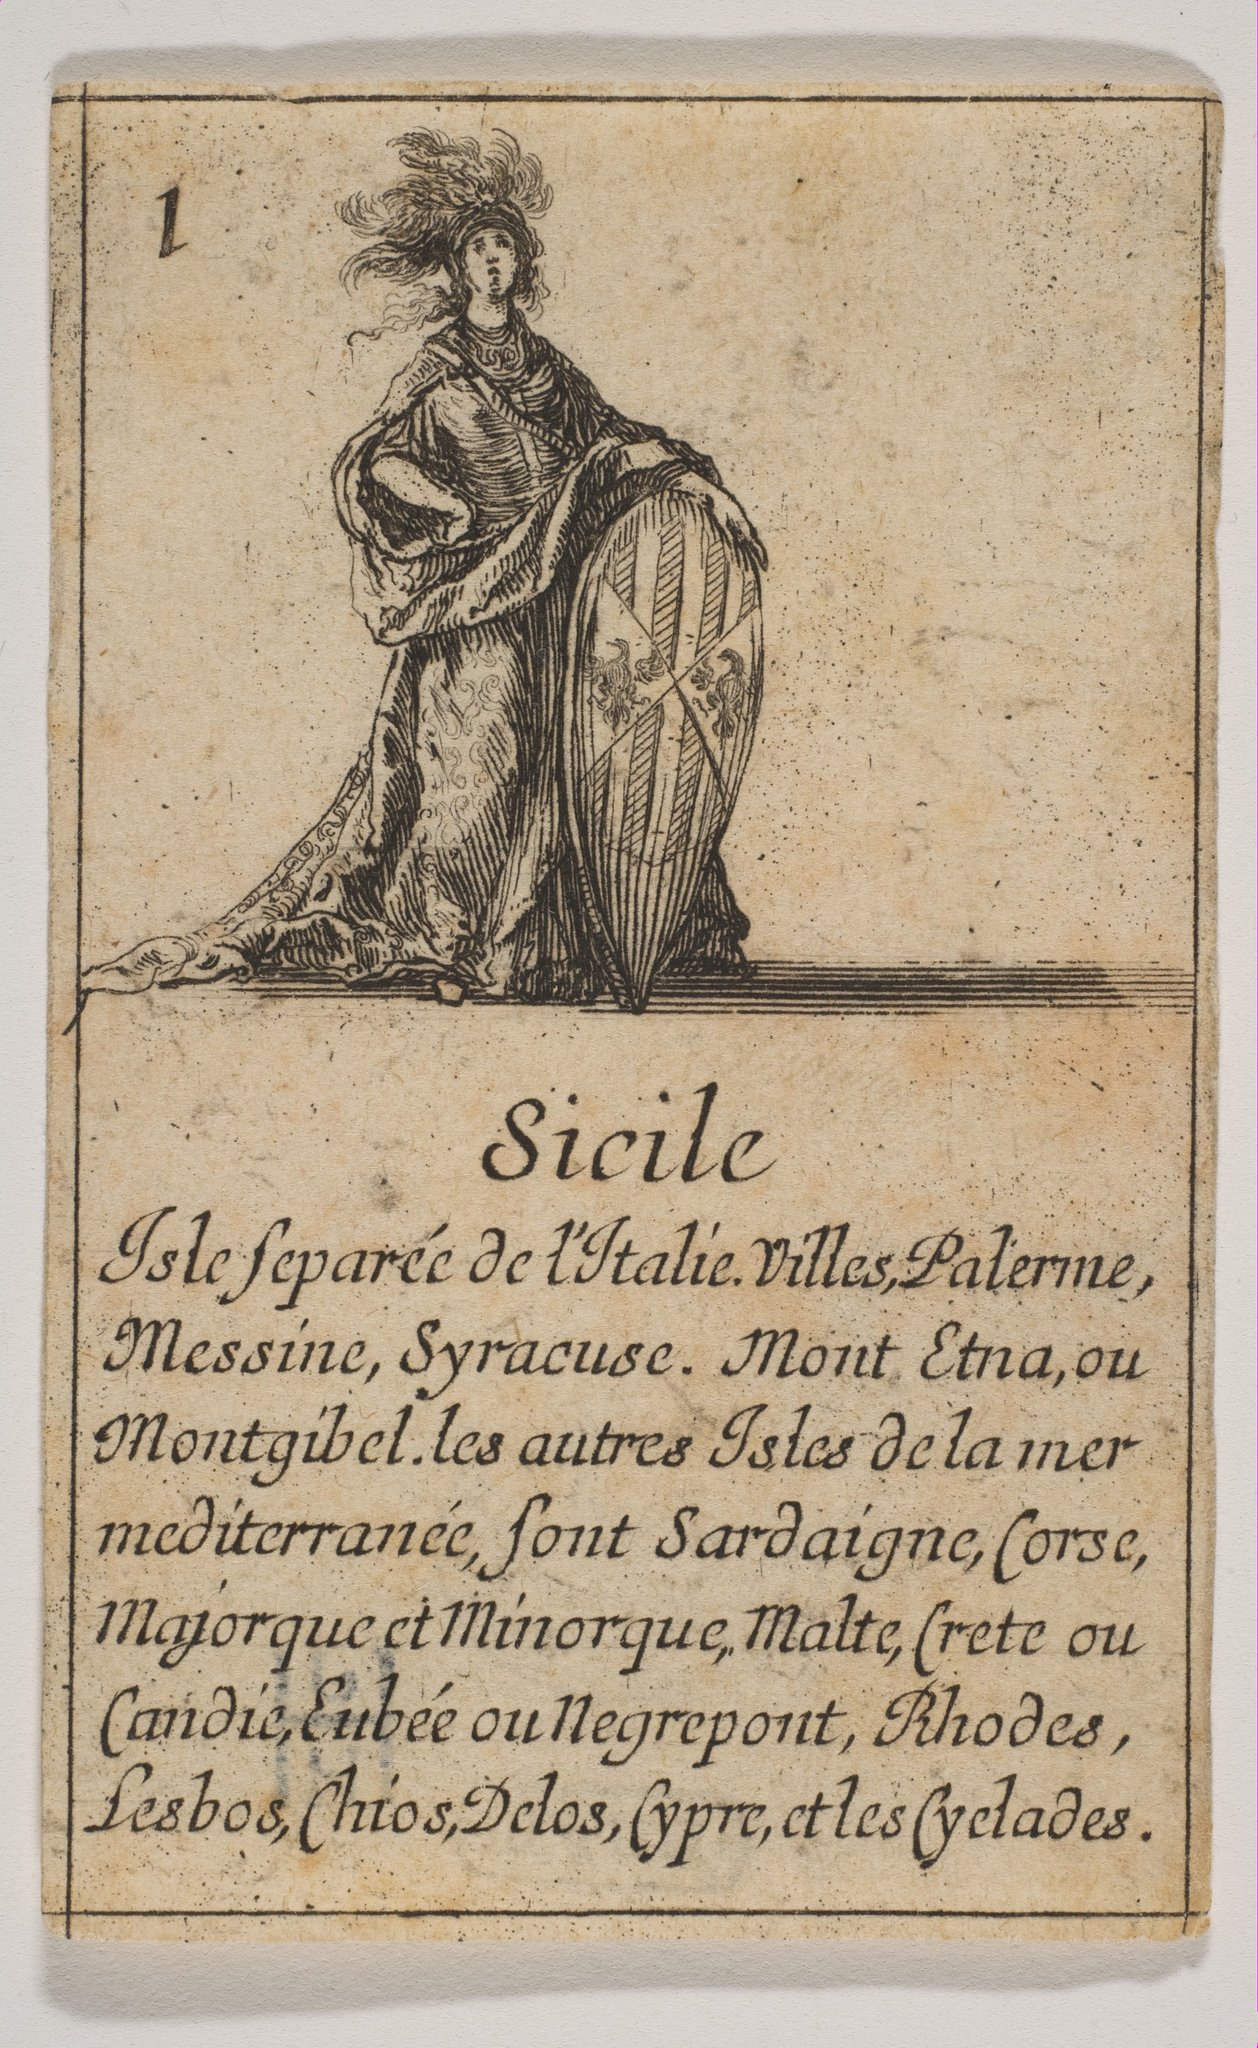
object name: print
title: Sicile, from "Jeu de la Géographie"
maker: stefano della bella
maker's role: artist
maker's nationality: italian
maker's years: 1610-1664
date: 1644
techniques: etching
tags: shields,men